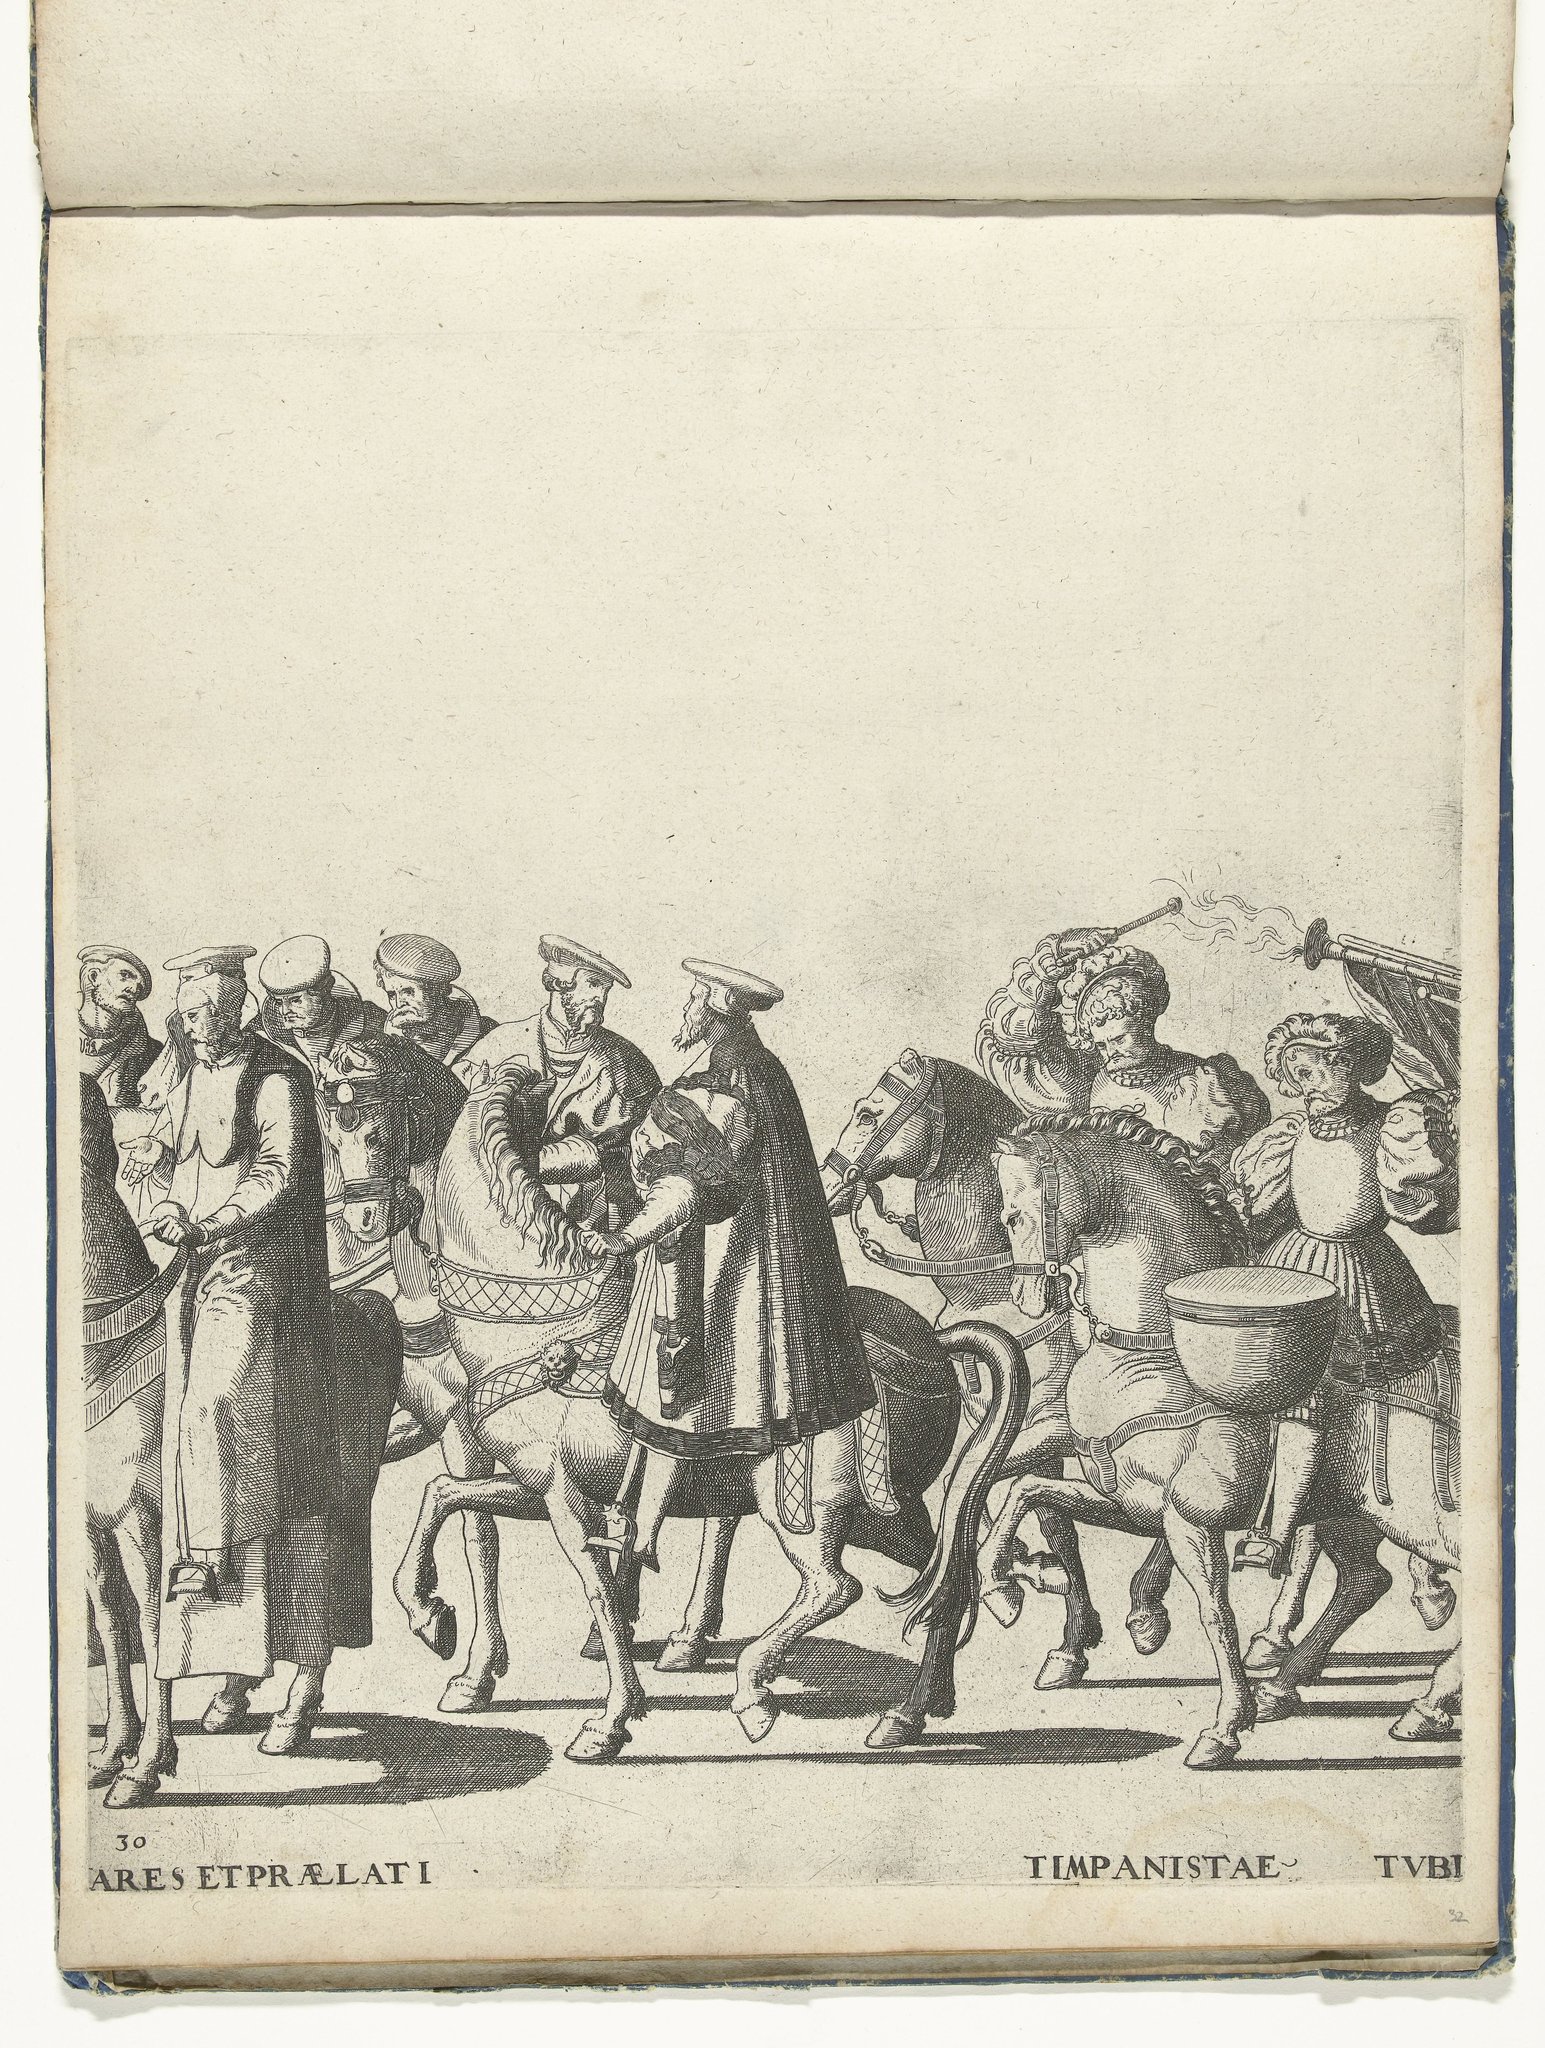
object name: propagandaprent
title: Optocht van Karel V met de paus te Bologna na zijn kroning to keizer, 1530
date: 1530-1536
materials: paper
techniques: engraving, etching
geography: the hague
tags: ghent, charles v (holy roman emperor and king of spain), rome, festivities (+ parade, pageant, cavalcade ~ festive activities)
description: Prent in het album waarin zijn ingeplakt de 40 platen die achterelkaar samen het fries vormen van de optocht van Karel V met de paus Clemens VII te Bologna na zijn kroning tot keizer, 24 februari 1530.